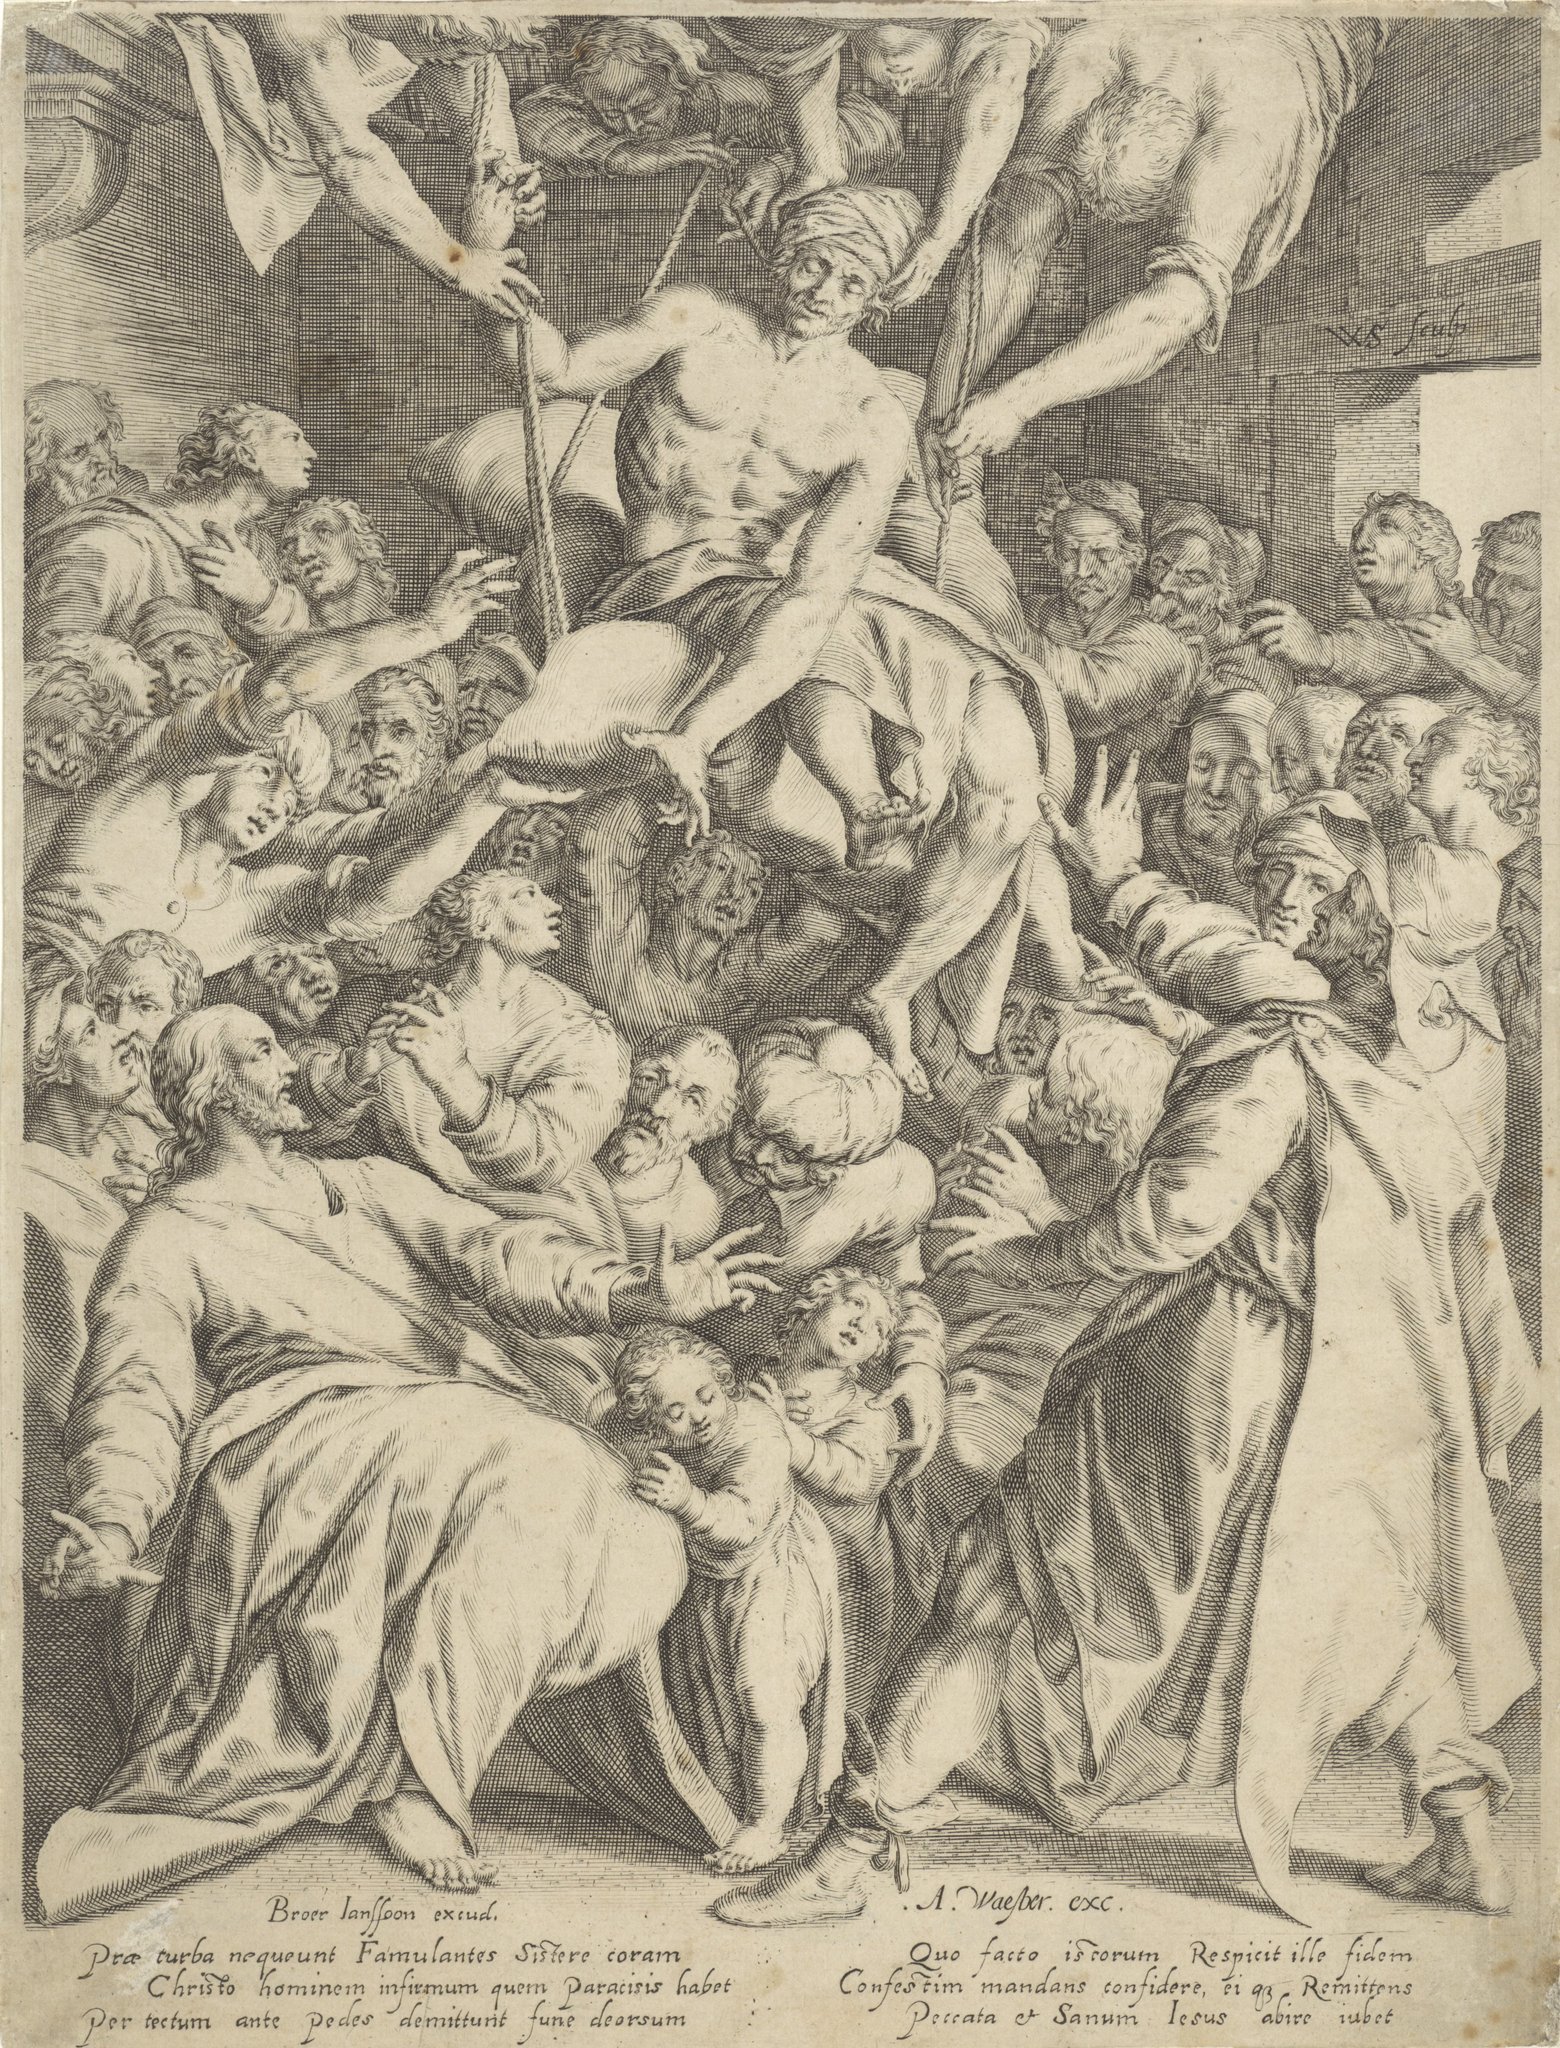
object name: print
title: Verlamde door het dak naar Christus neergelaten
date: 1624-1639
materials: paper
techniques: engraving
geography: amsterdam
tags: a paralytic is let down through the roof of the house where christ is preaching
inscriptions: collector's mark: Lugt 2228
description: Voorstelling van een wonderbaarlijke genezing. Christus staat voor een groep mensen. Door het dak wordt een verlamde man op zijn matras aan touwen neergelaten. Onder de voorstelling bevindt zich een zesregelige, Latijnse tekst waarin de scène wordt beschreven.